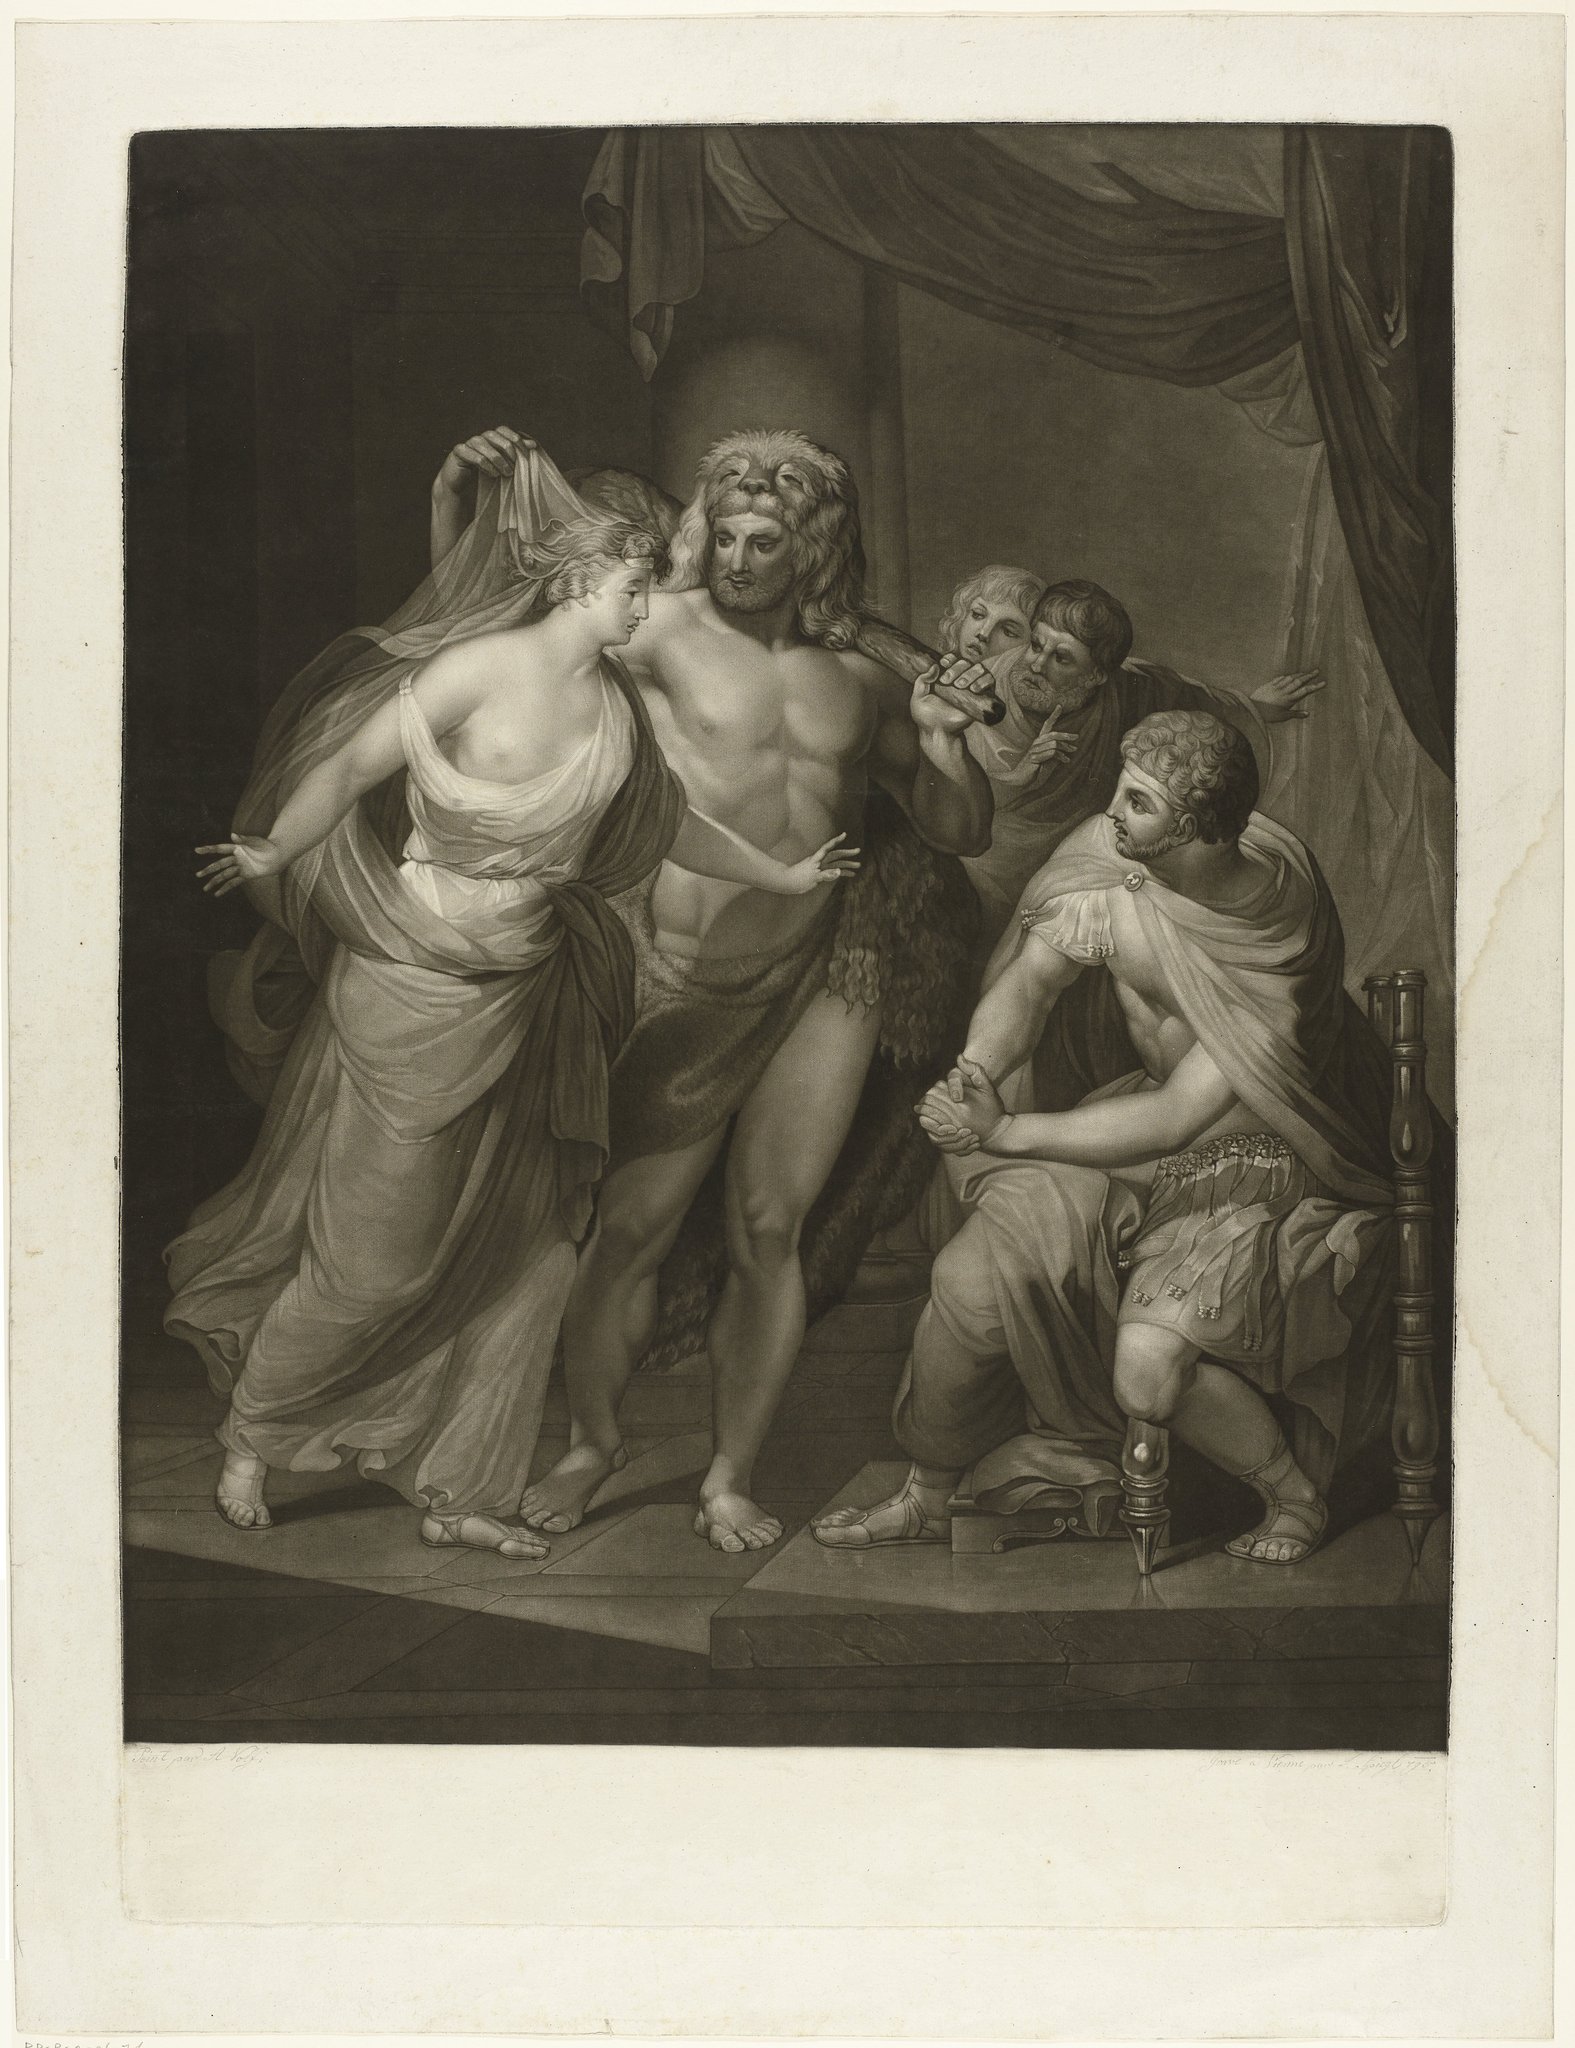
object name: print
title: Hercules brengt Alcestis terug uit de onderwereld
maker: joseph spiegl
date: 1795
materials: paper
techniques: mezzotint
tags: hercules leads alcestis out of the underworld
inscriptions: collector's mark: Lugt 2760, collector's mark: Lugt 2228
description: Hercules redt Alcestis uit de onderwereld en brengt haar terug naar haar echtgenoot Admetus. Hercules tilt de sluier van Alcestis op en toont haar aan Admetus, die zijn handen ineenslaat.